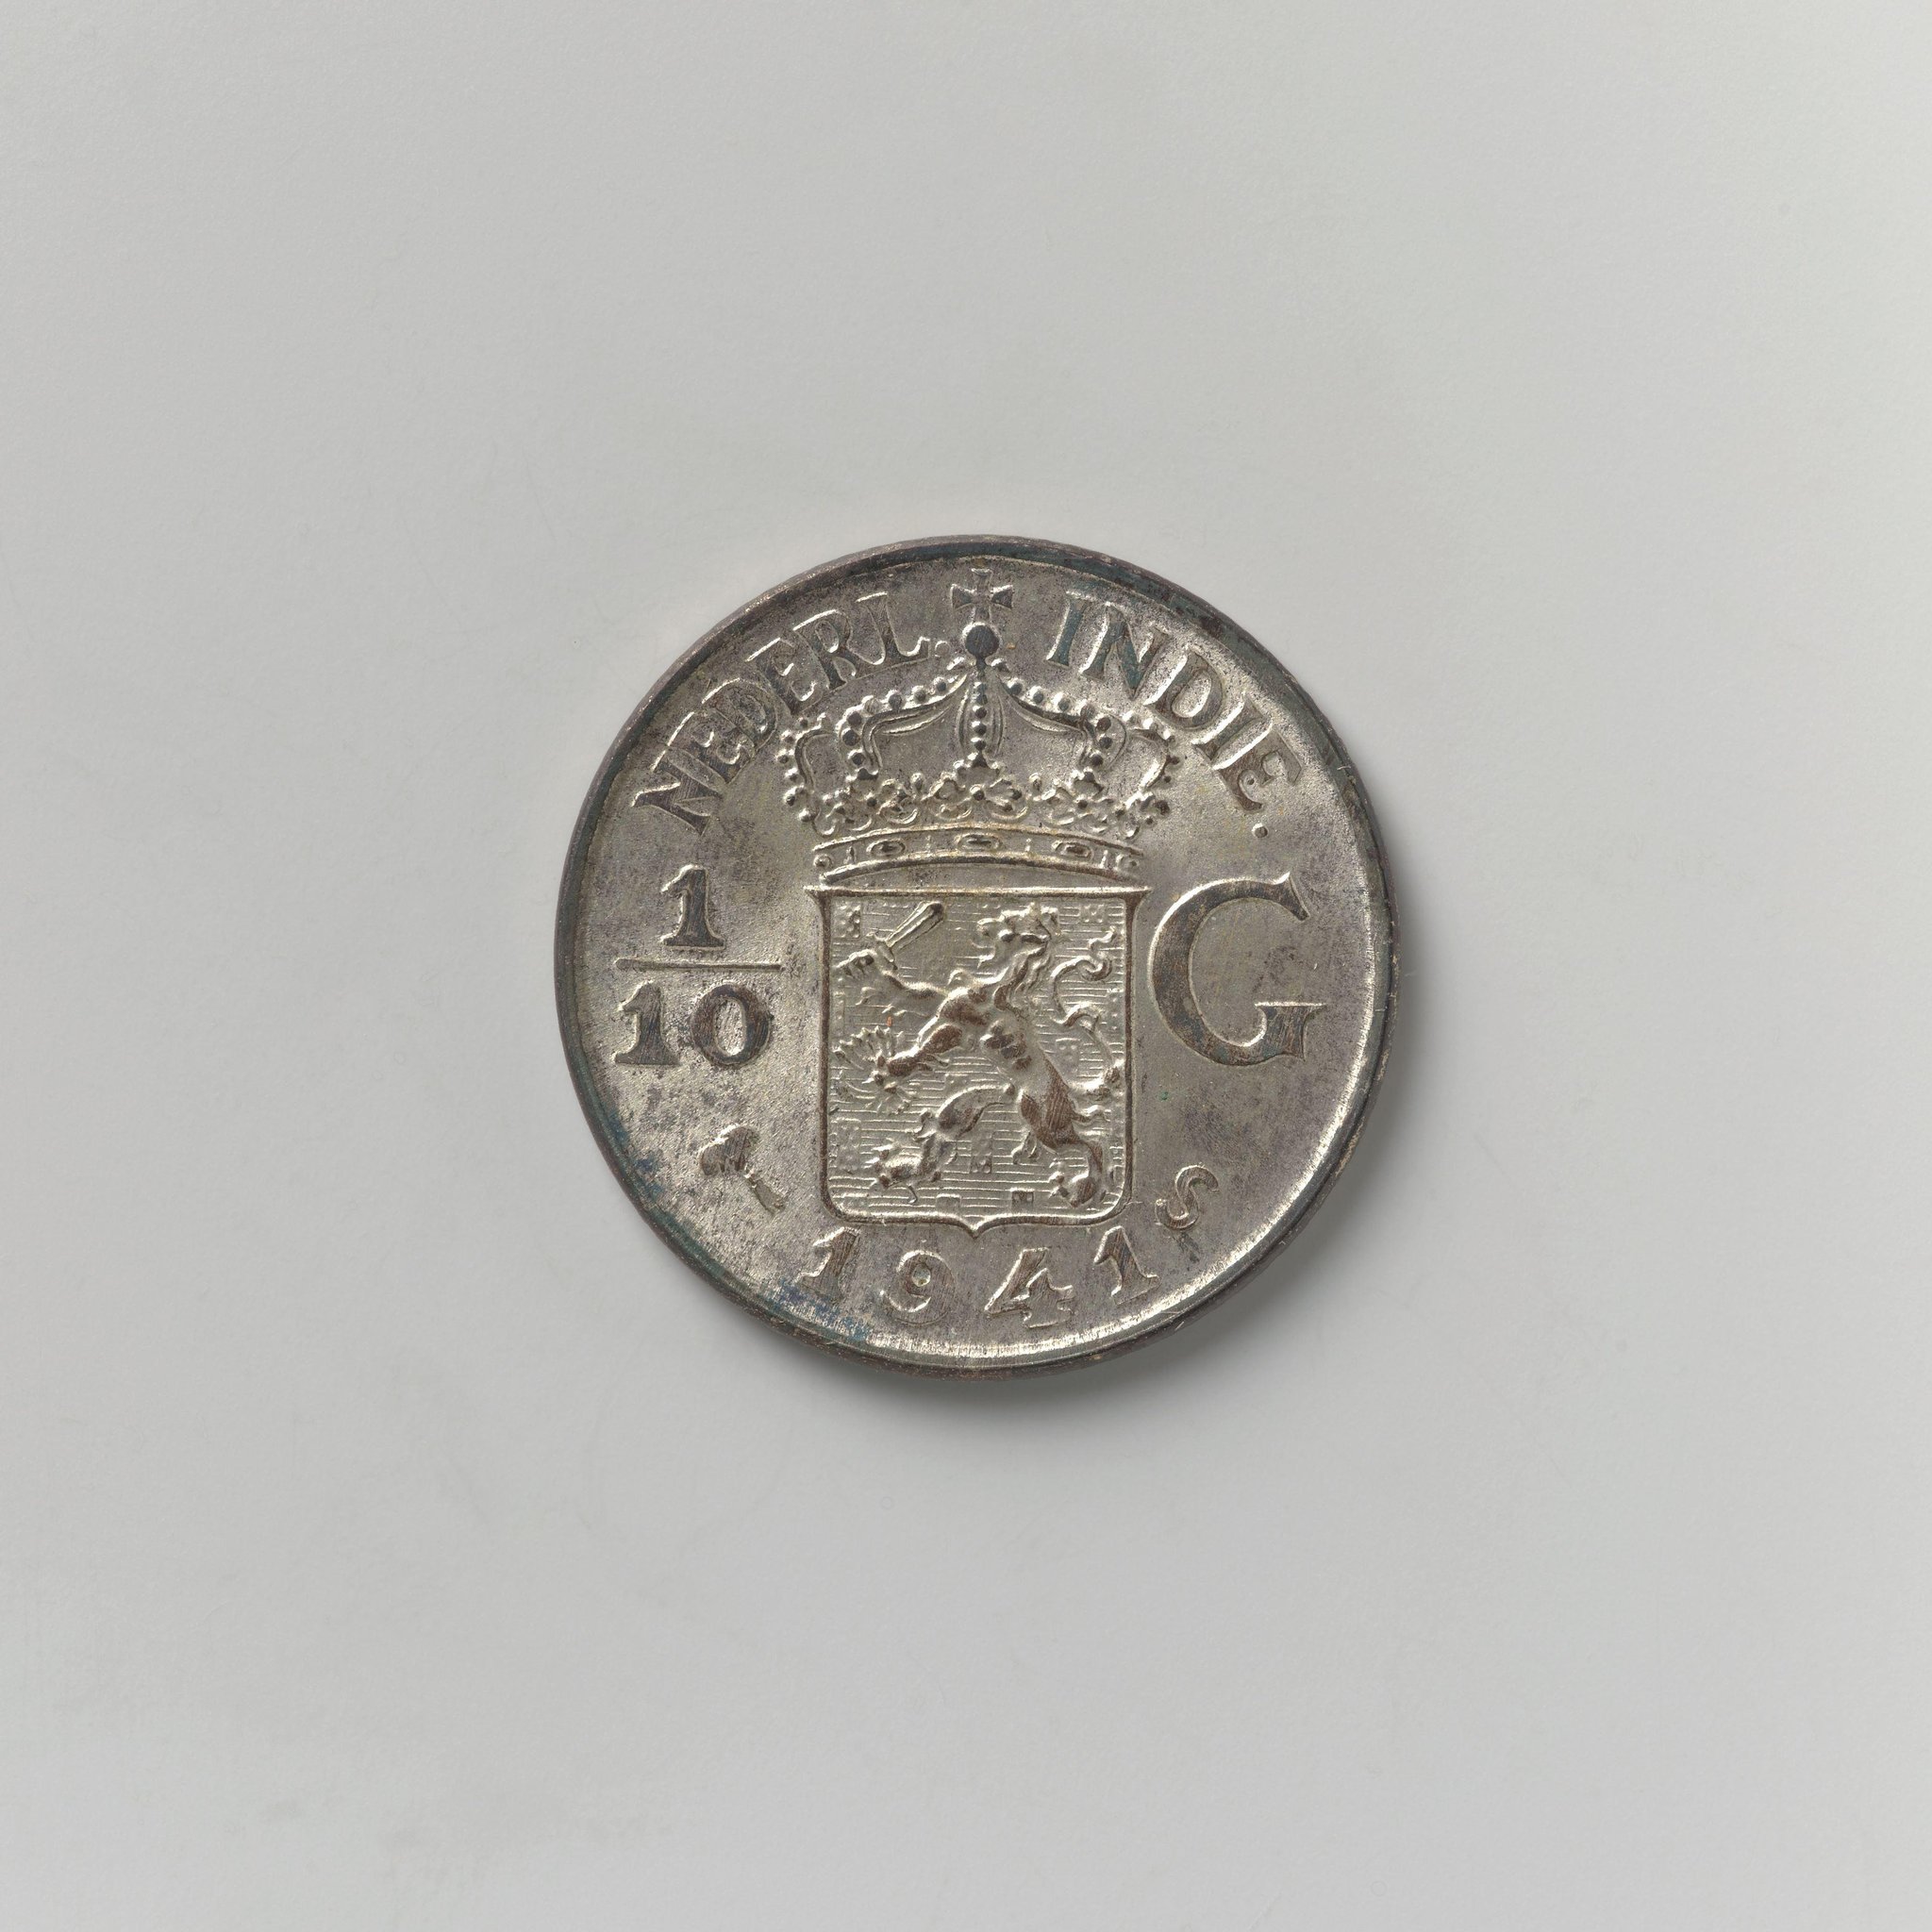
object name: coin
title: 1/10 gulden van Nederlands Indië,1941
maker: wilhelmina of the netherlands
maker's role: print maker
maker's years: 1880-1962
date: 1941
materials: copper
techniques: striking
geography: san francisco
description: Zilveren munt. Voorzijde: tussen waarde-aanduiding 1/10 G gekroond rijkswapenschild. Boven kroon landsaanduiding en onder wapenschild jaartal. Keerzijde: tweeregelig Maleis opschrift in Arabische tekens, waaromheen omschrift in het Javaans. Kartelrand.